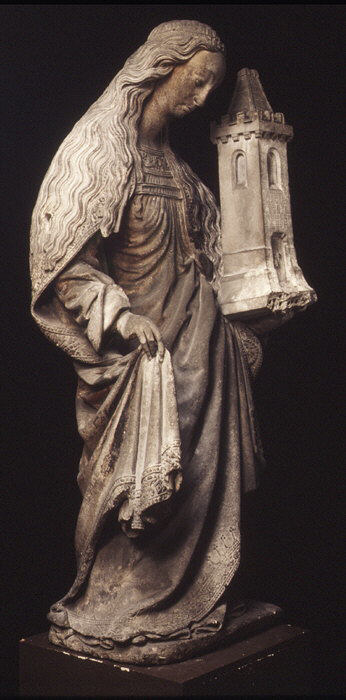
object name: statue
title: Saint Barbara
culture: french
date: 1501-1600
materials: stone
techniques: gilding, painting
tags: towers,women